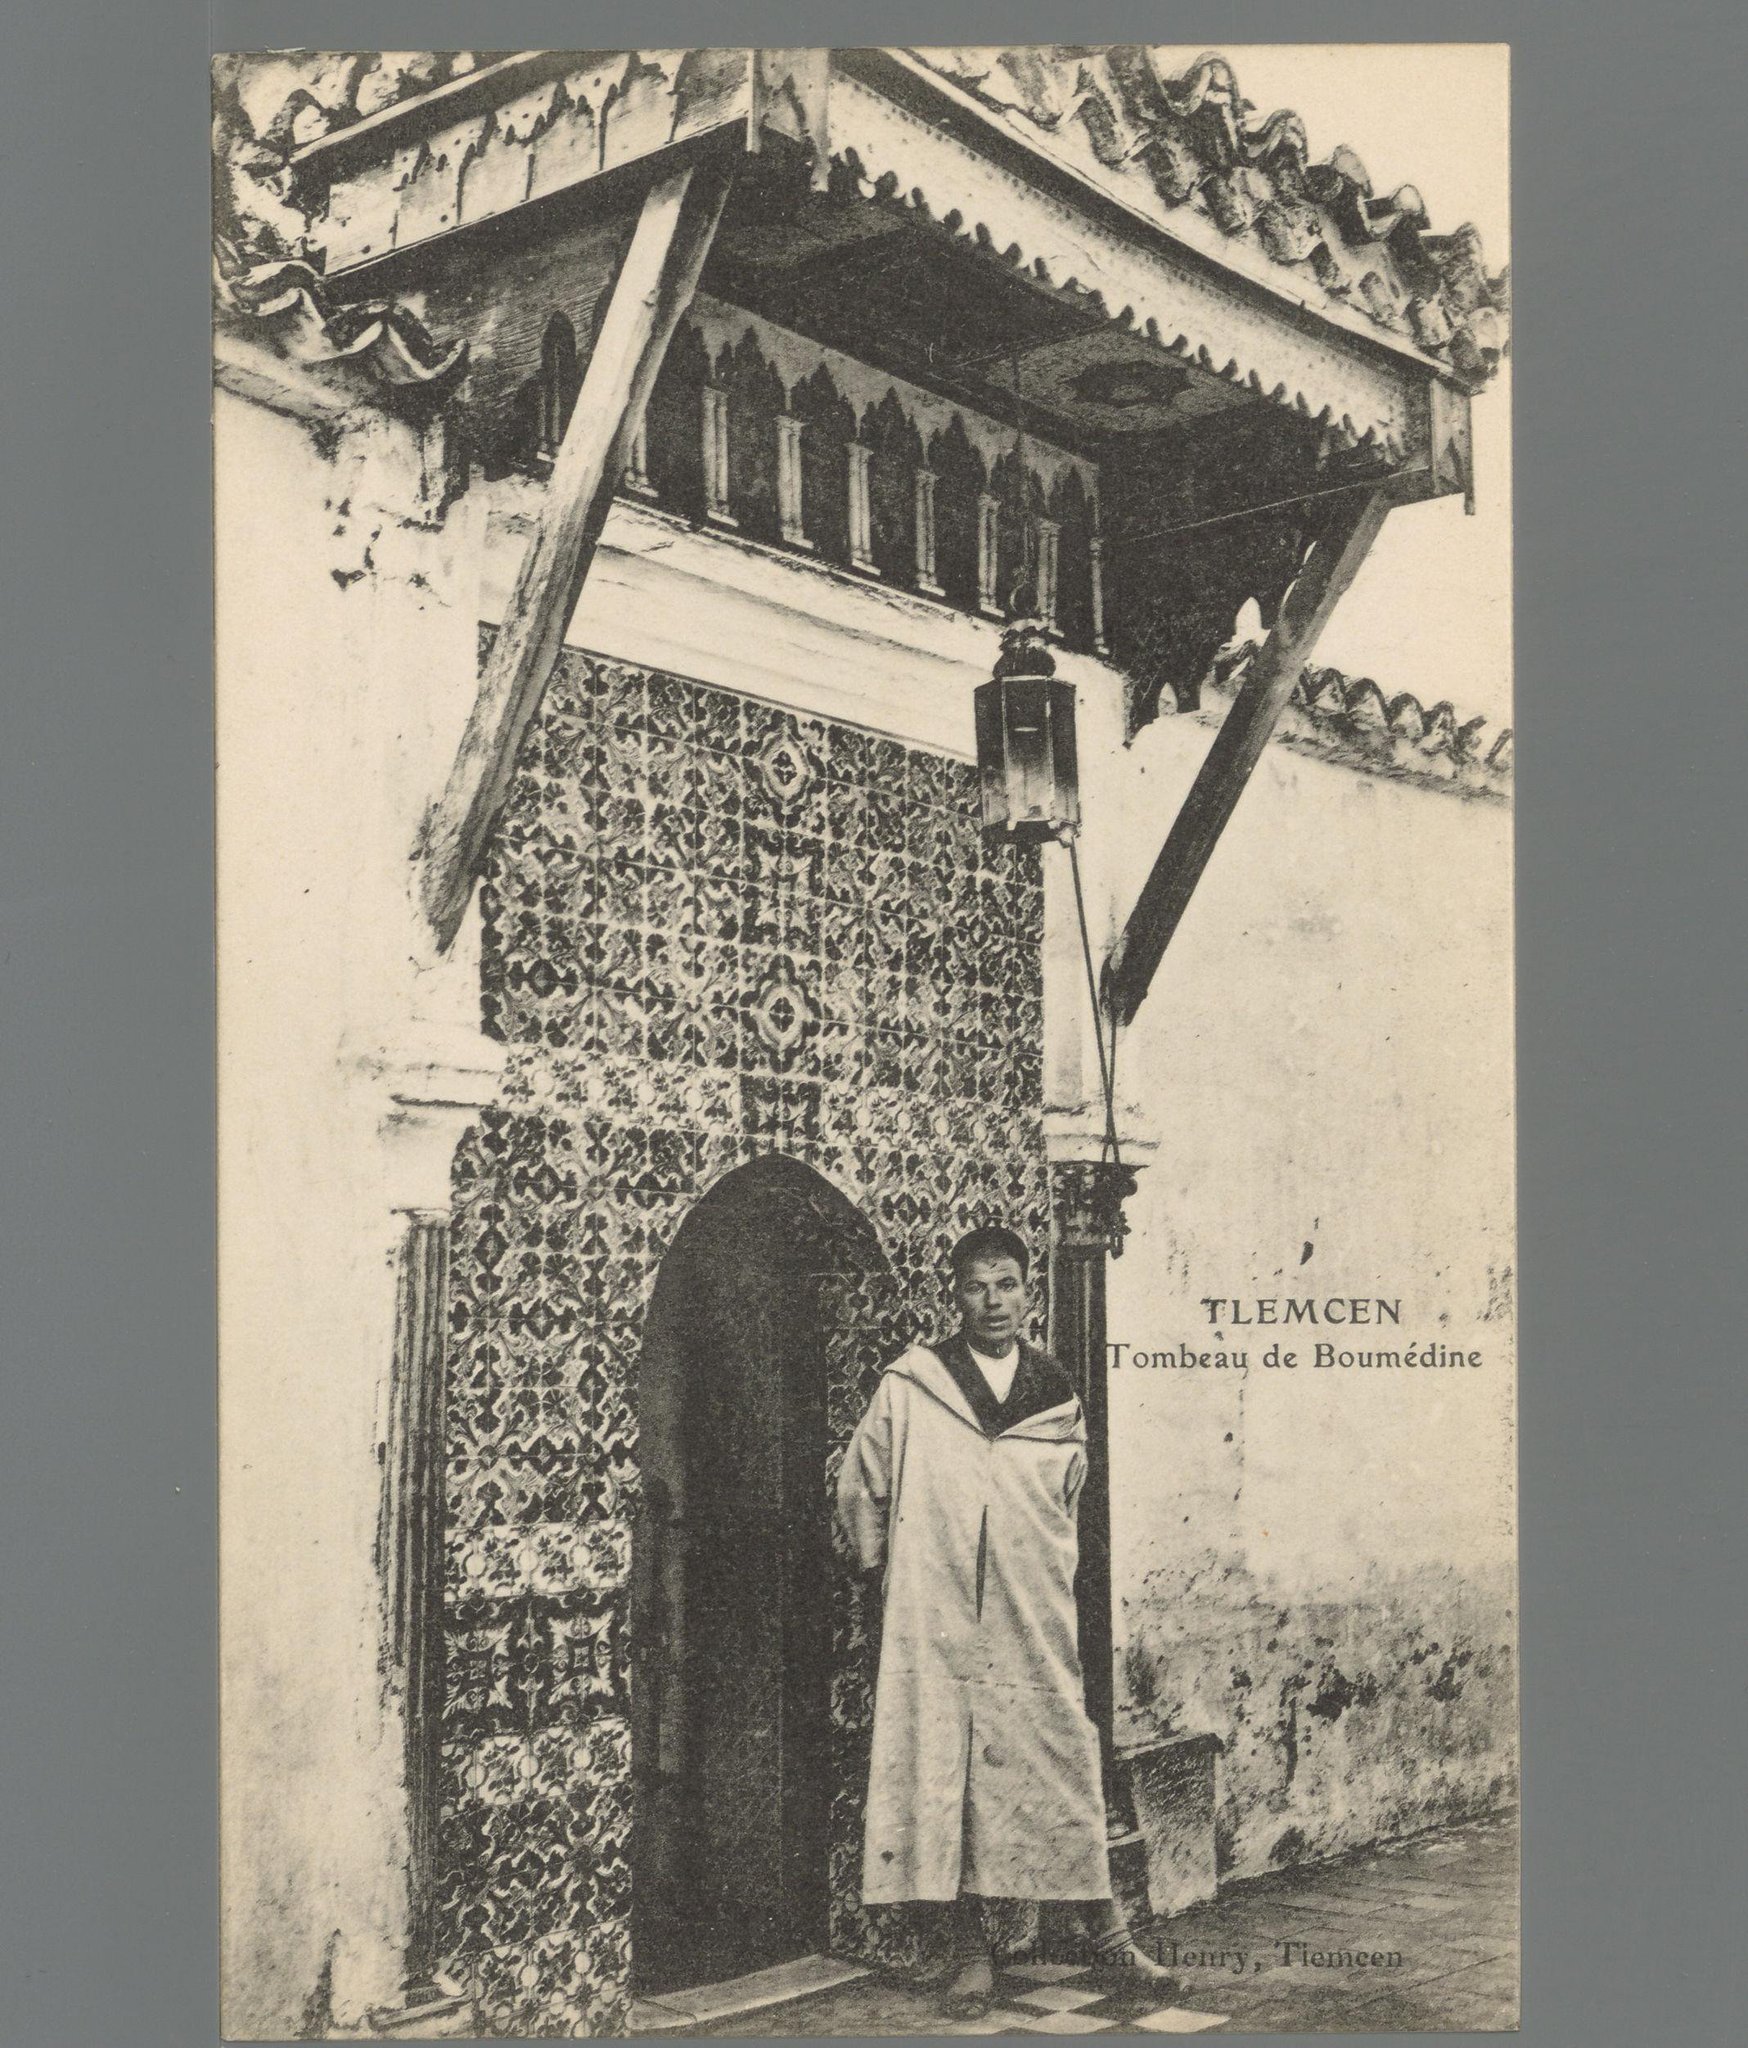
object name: ansichtkaart, prentbriefkaart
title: Tlemcen. Tombeau de Boumédine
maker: Anonymous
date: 1903-1905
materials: cardboard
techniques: photograph, writing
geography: tlemcen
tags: monumental door, porch, 'aediculum', adult man, grave, tomb